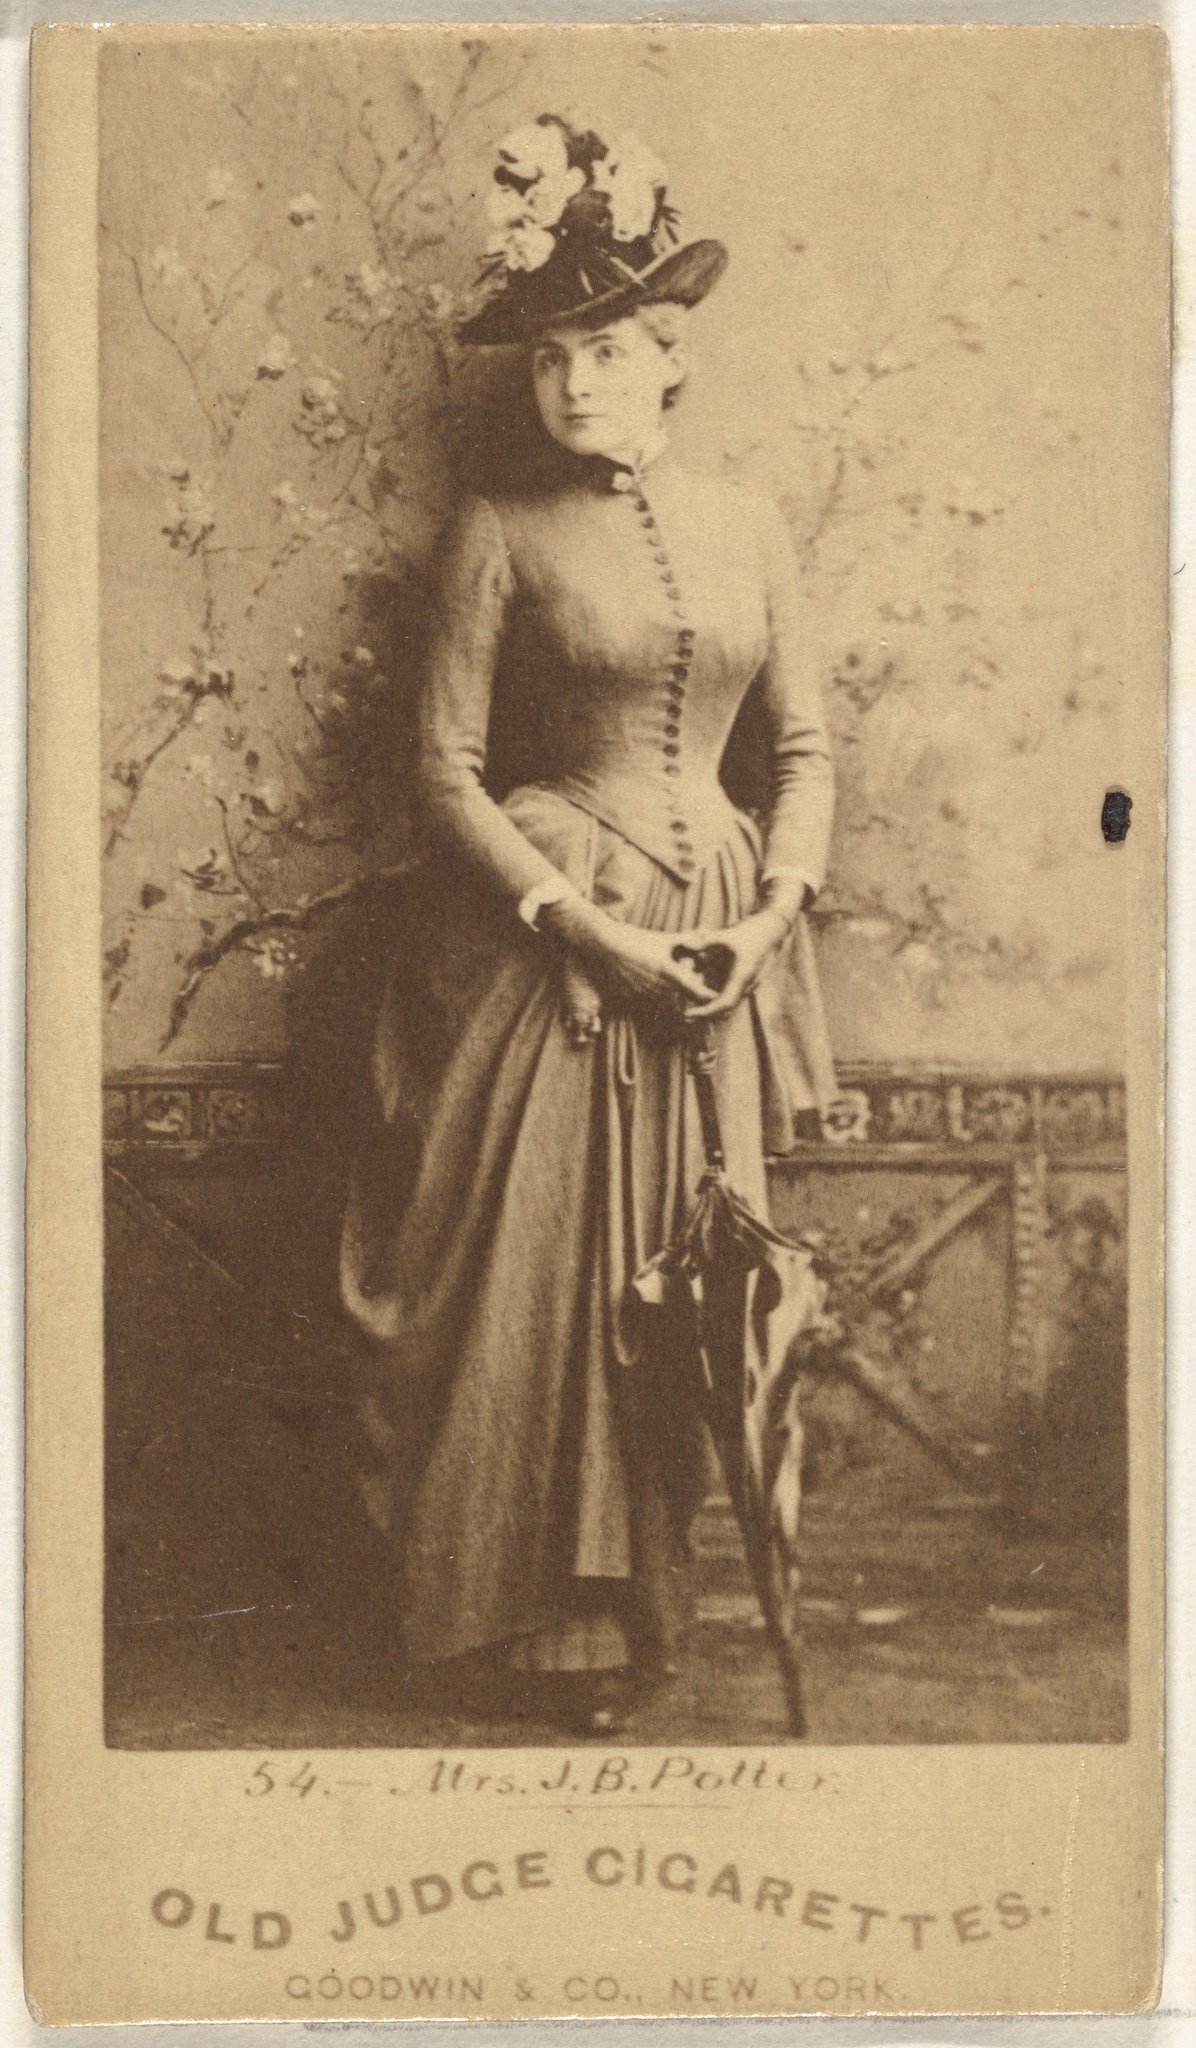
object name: photograph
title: Mrs. J.B. Potter, from the Actors and Actresses series (N171) for Old Judge Cigarettes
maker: goodwin & company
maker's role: publisher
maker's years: 1850-1950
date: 1886-1890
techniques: albumen silver print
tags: portraits,women,actresses